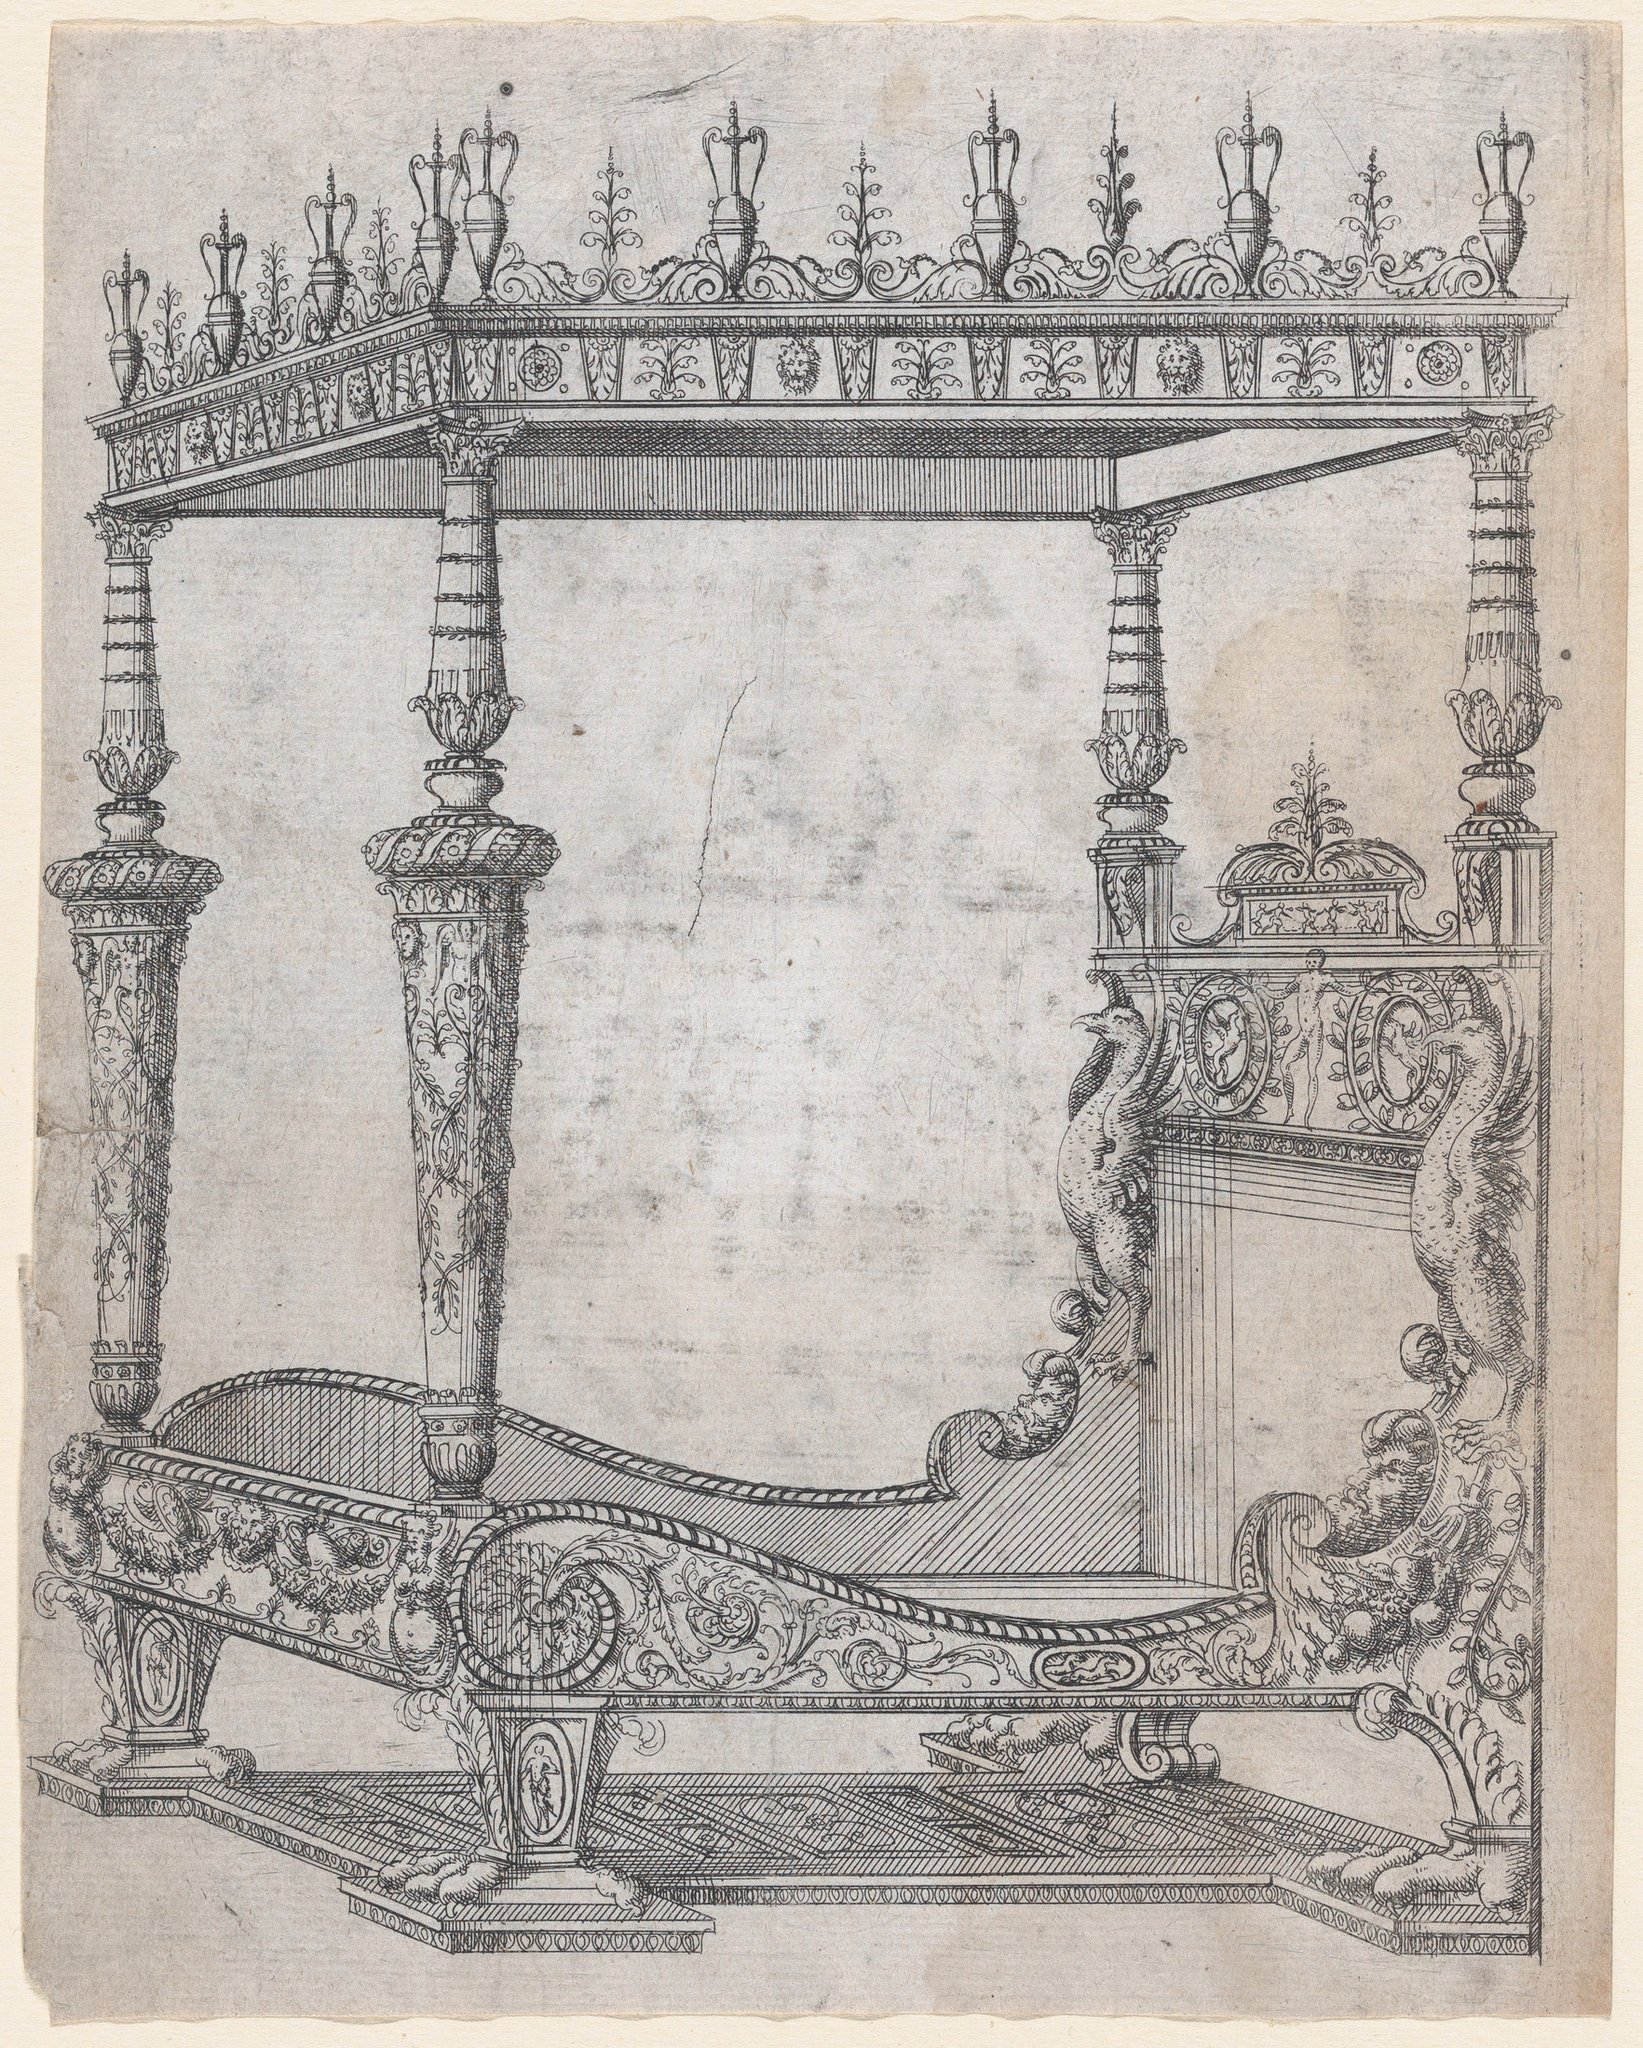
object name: print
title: Design for a Four Poster Bed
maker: jacques androuet du cerceau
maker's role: artist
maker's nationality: french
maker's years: 1510-1585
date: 1565-1570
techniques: etching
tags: beds